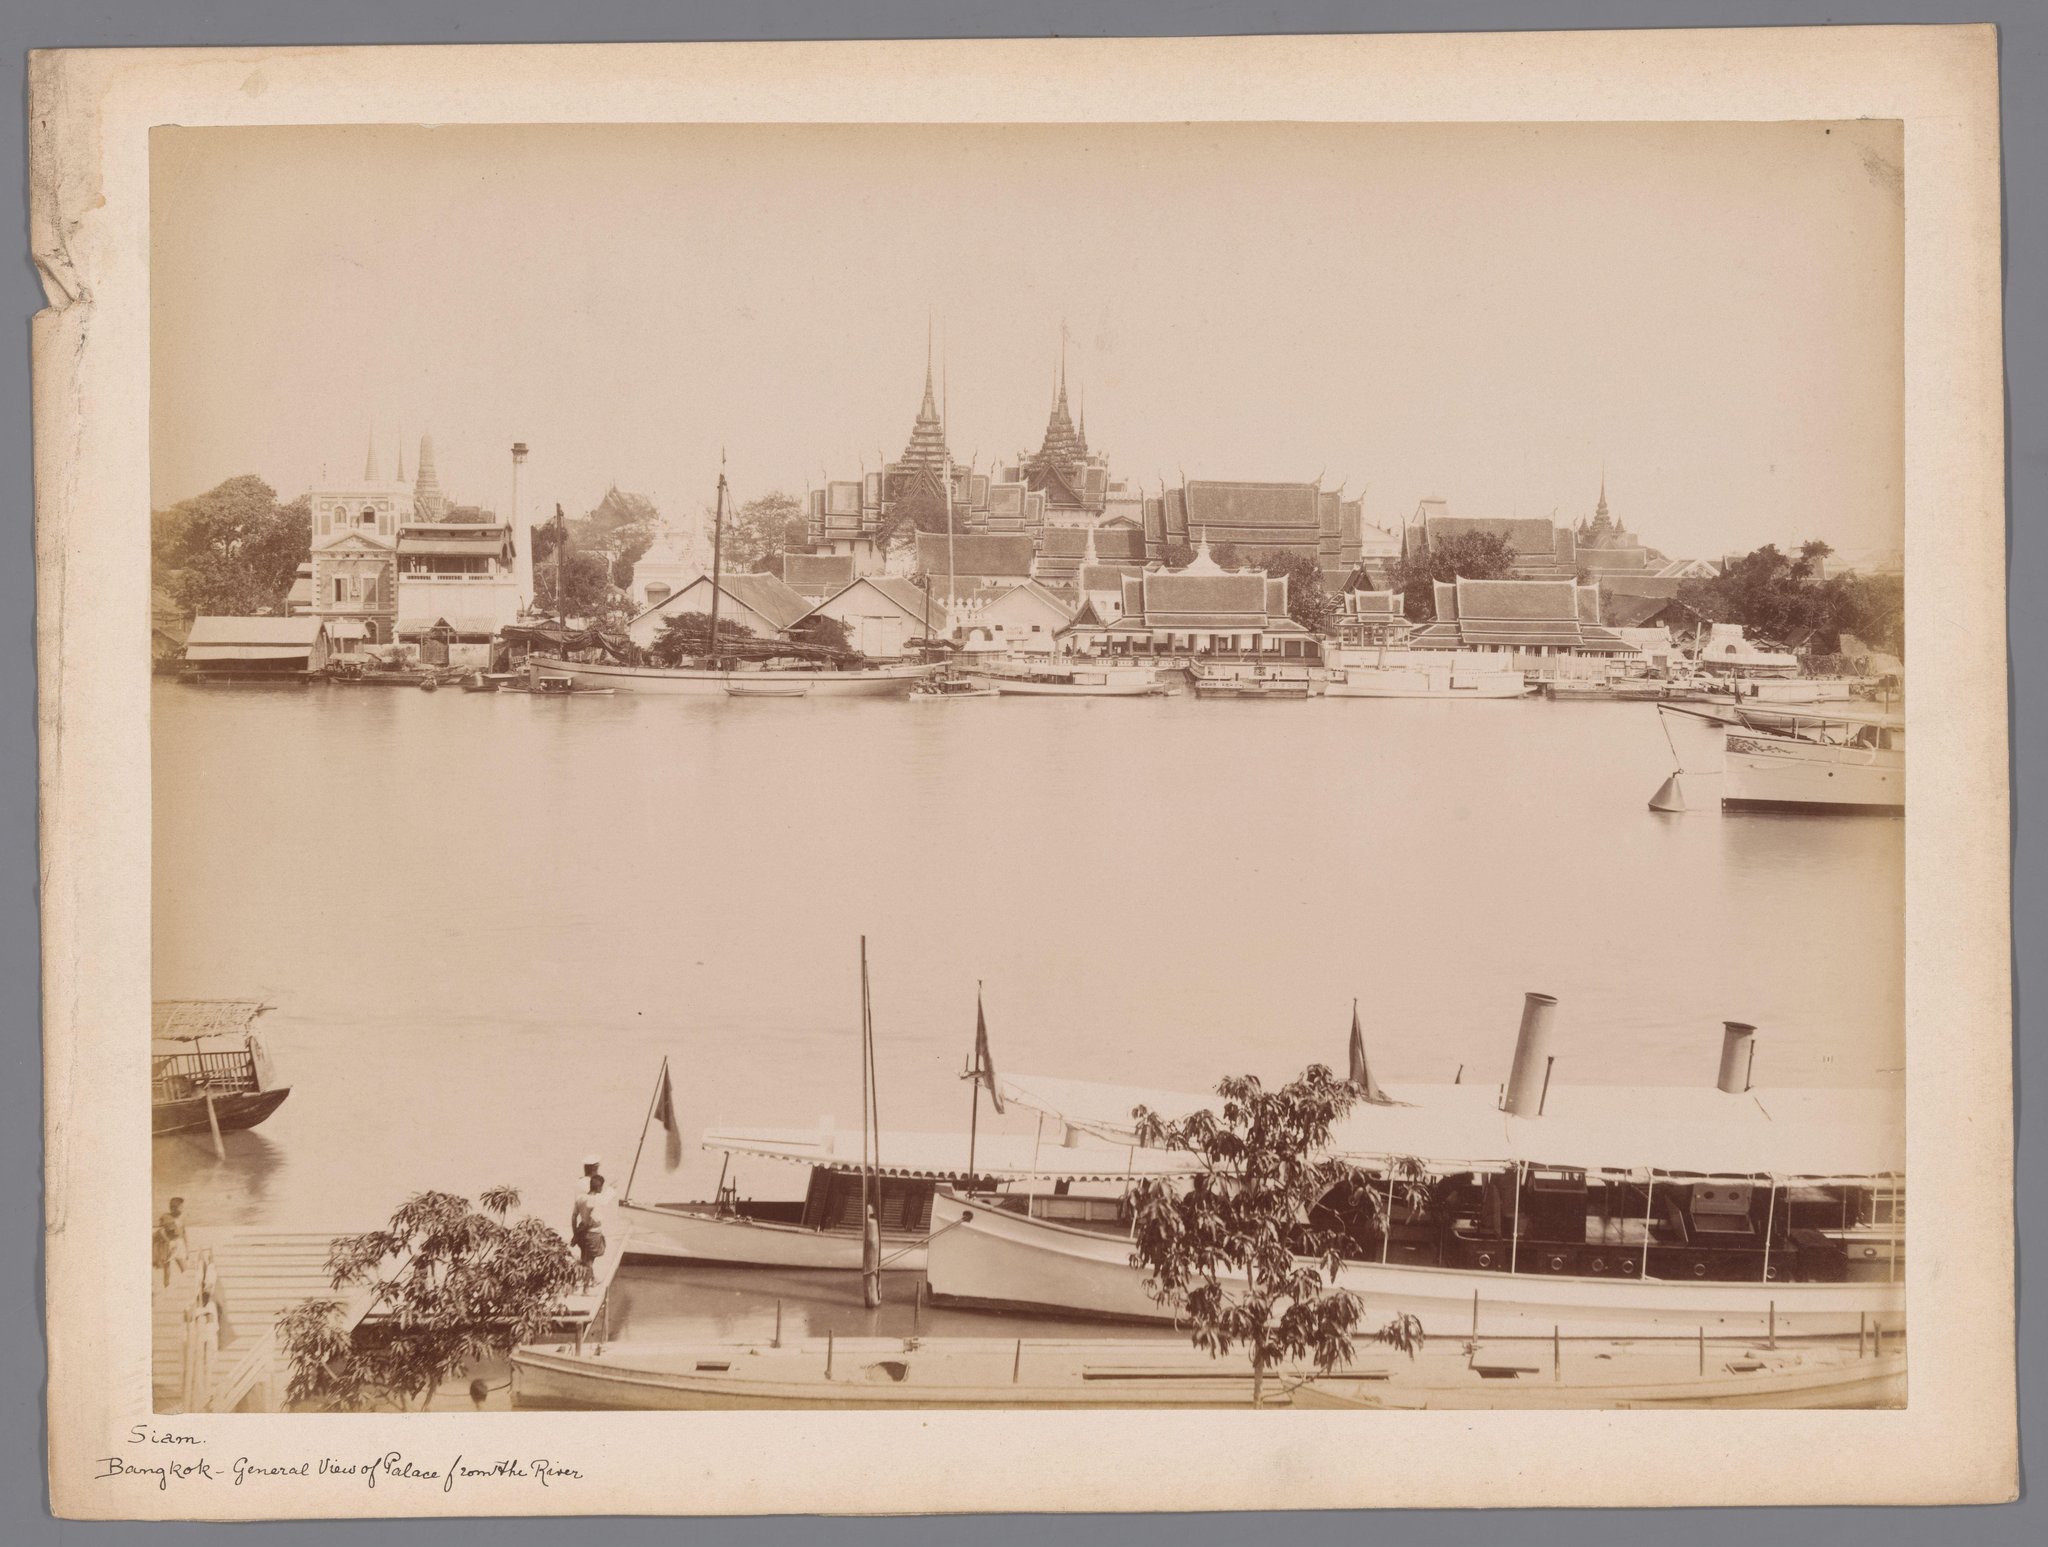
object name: photograph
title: Siam, Bangkok - general view of Palace from the River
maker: Anonymous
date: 1860-1900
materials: cardboard, paper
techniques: albumen print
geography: bangkok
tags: palace